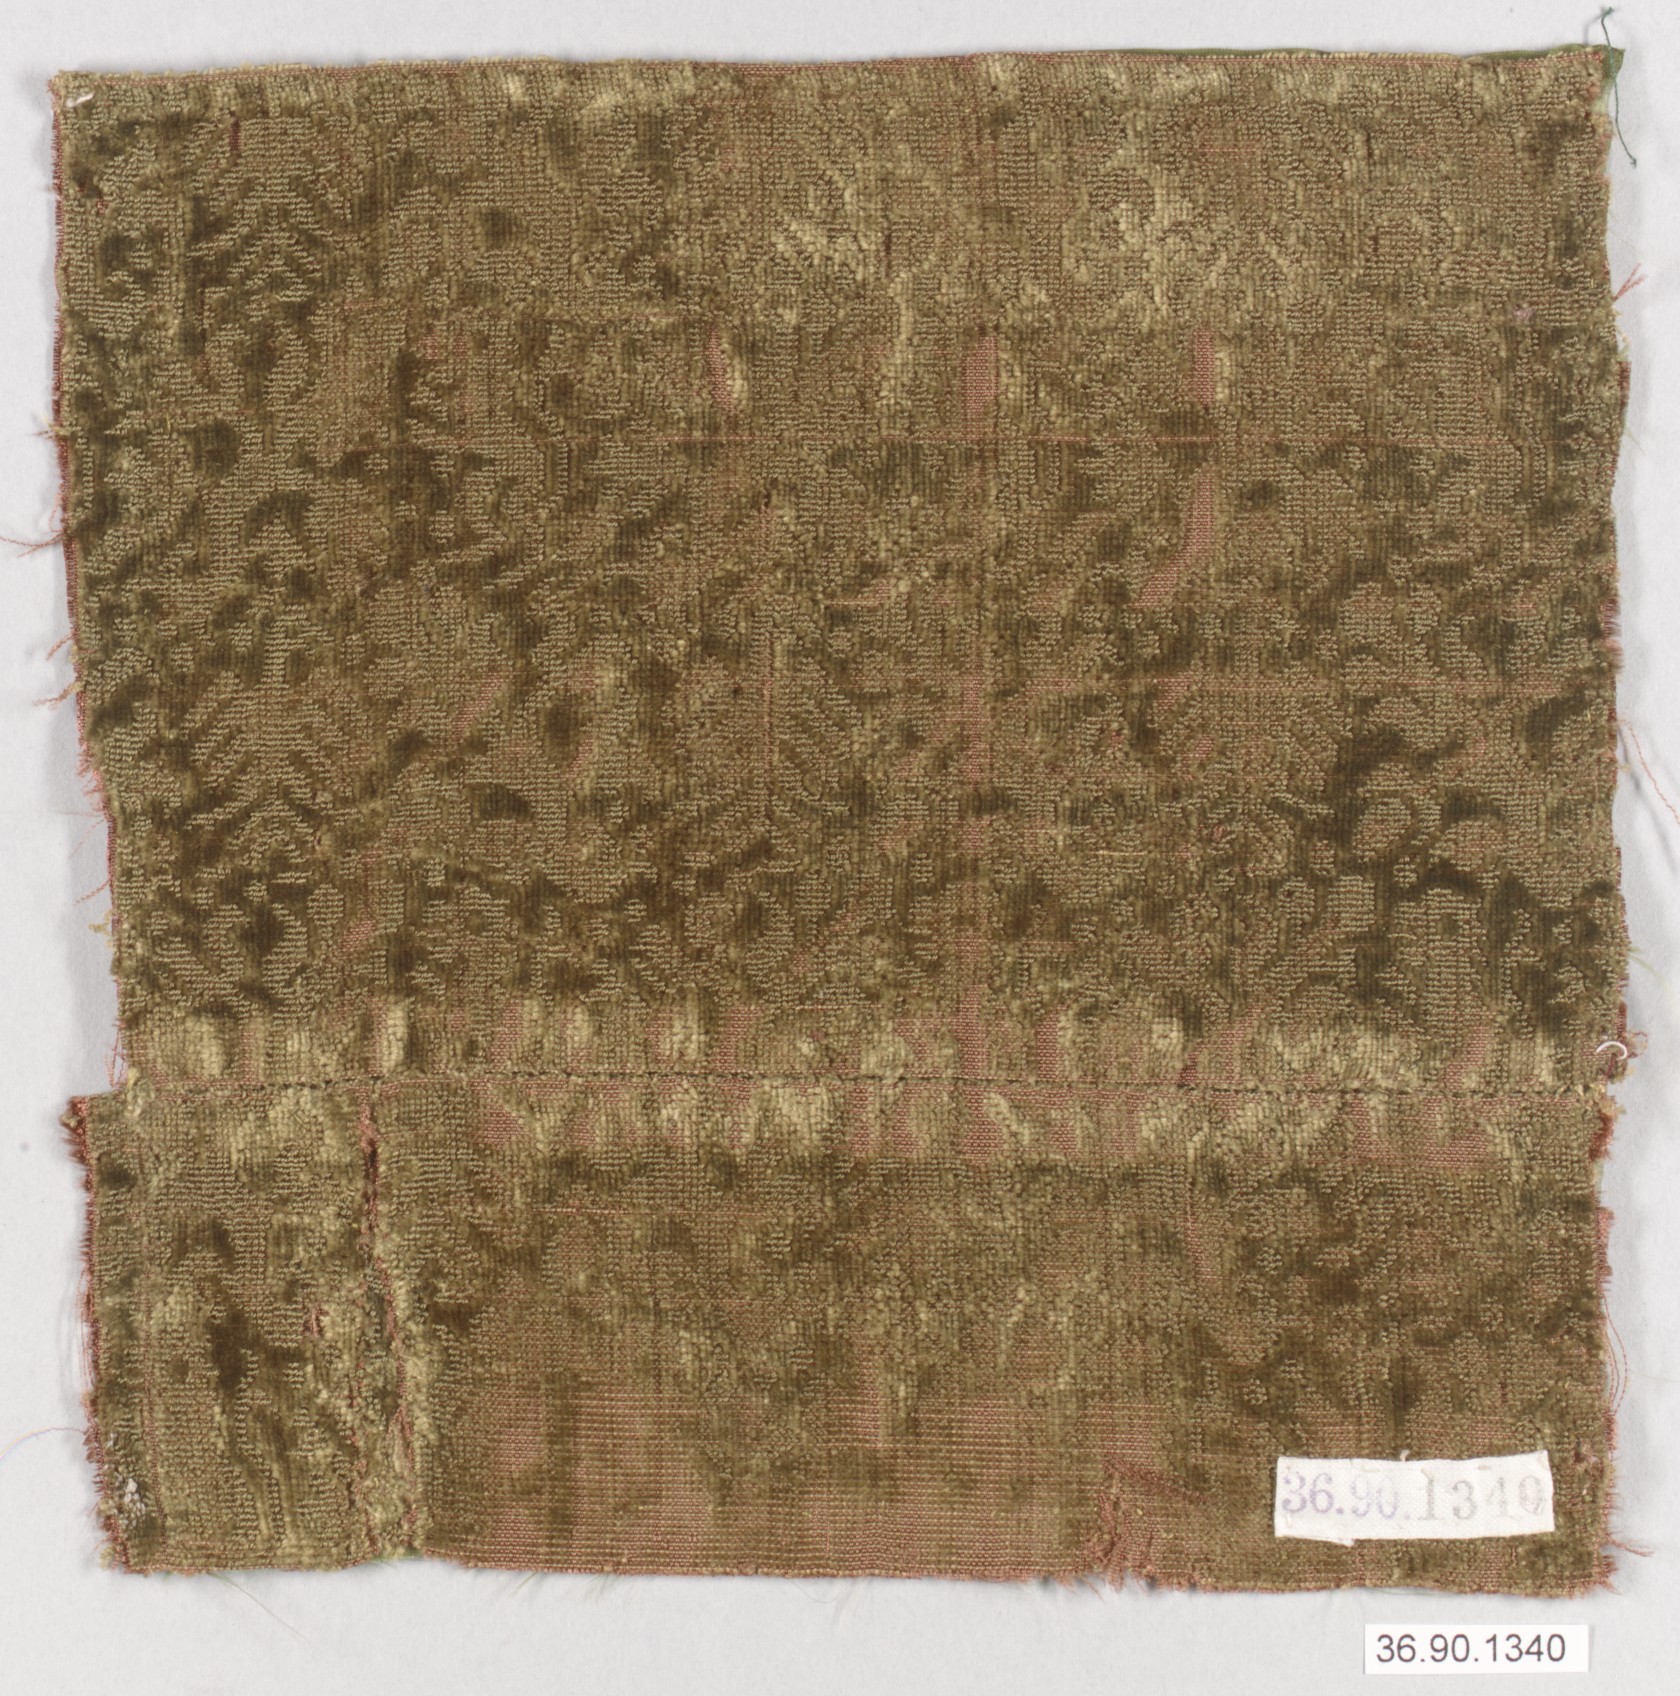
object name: piece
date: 1501-1700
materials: silk